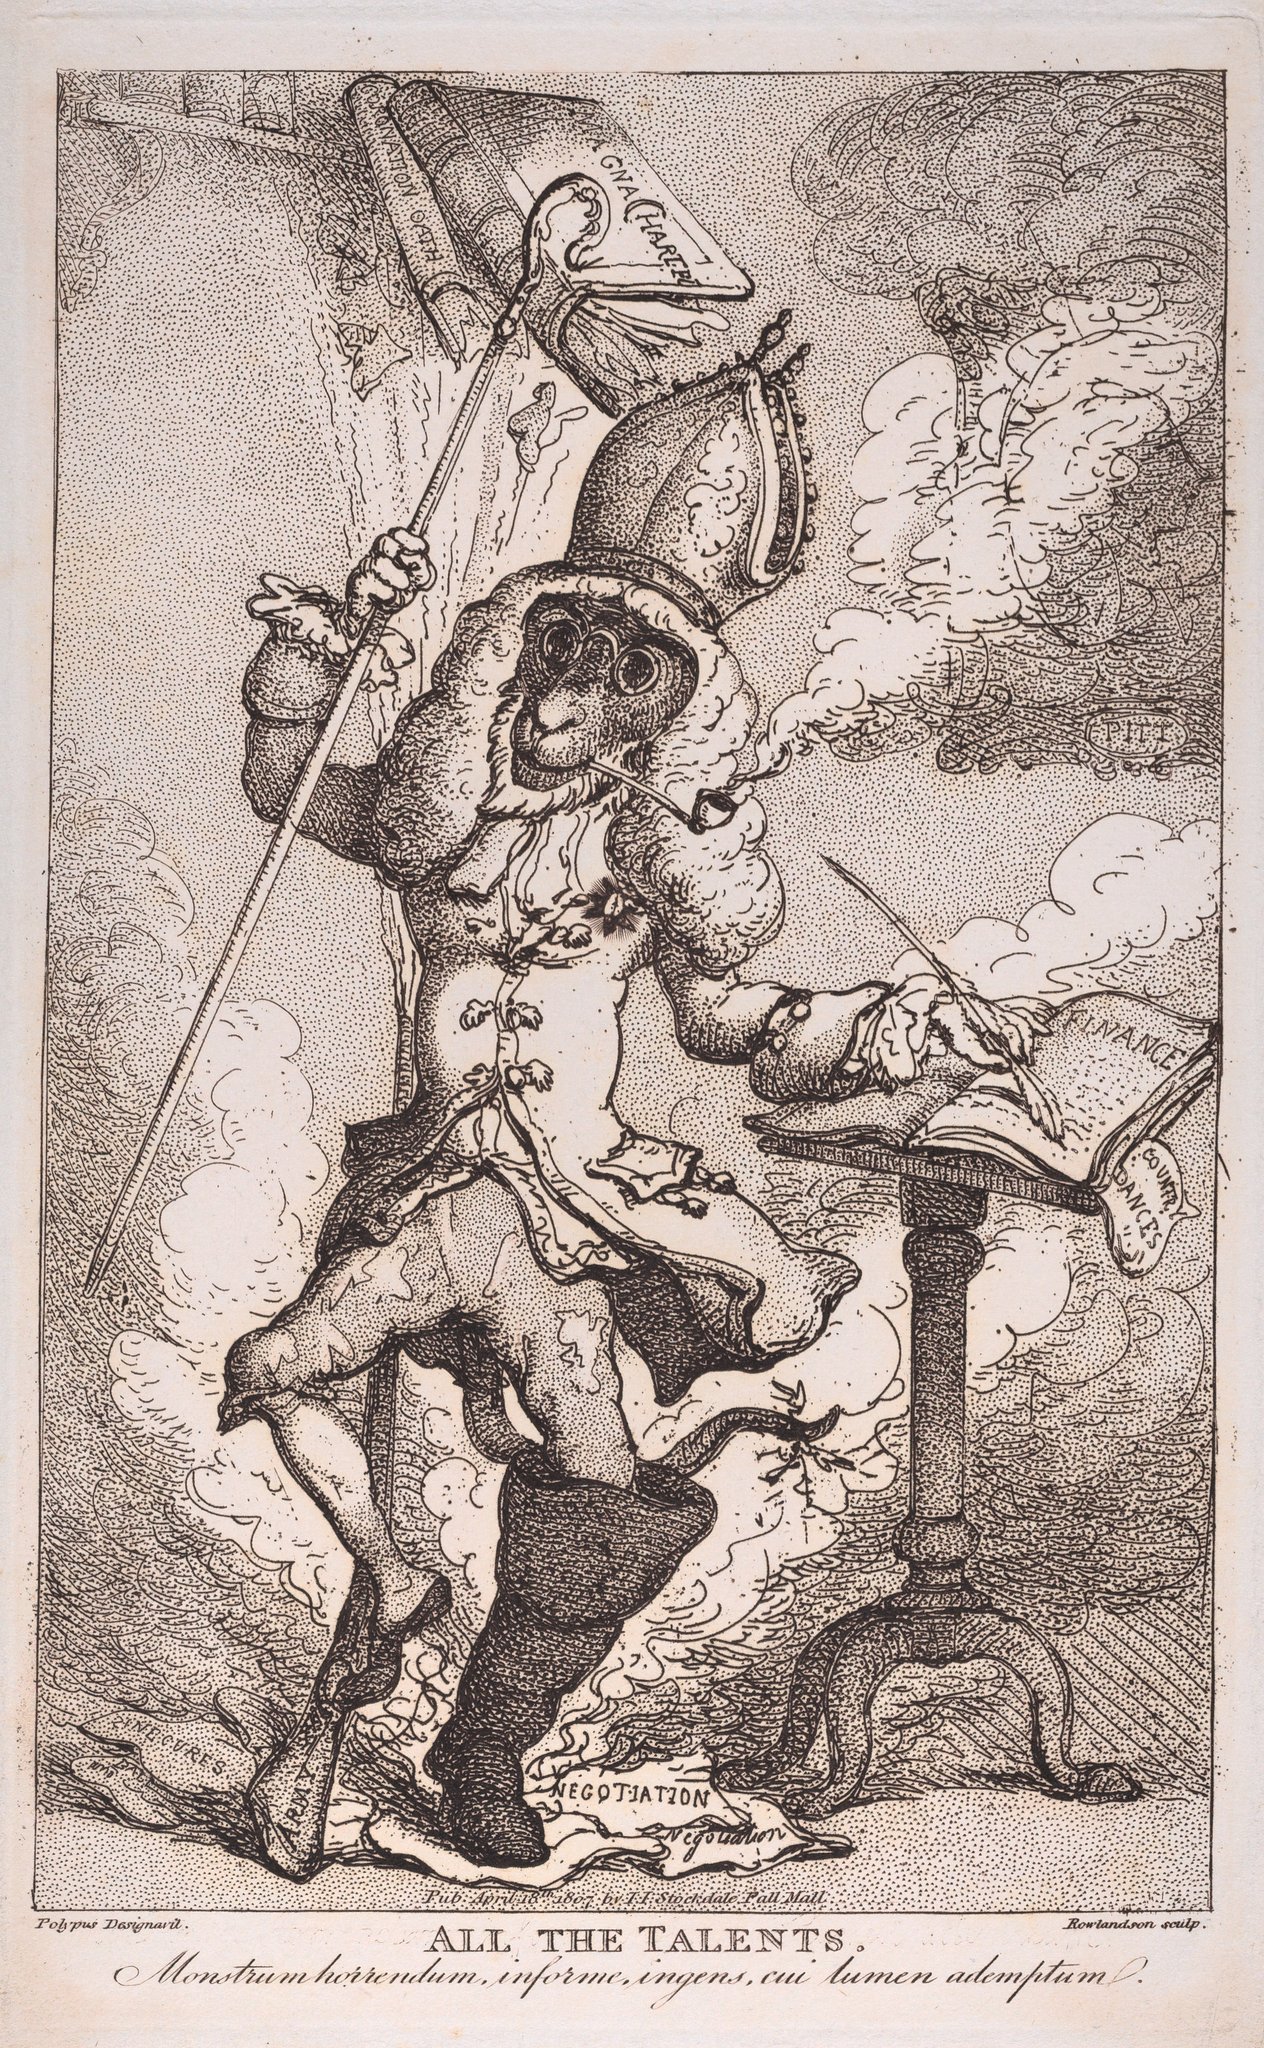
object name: print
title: All the Talents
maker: thomas rowlandson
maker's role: artist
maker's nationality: british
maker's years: 1757-1827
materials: ink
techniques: etching, printing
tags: satire,allegory